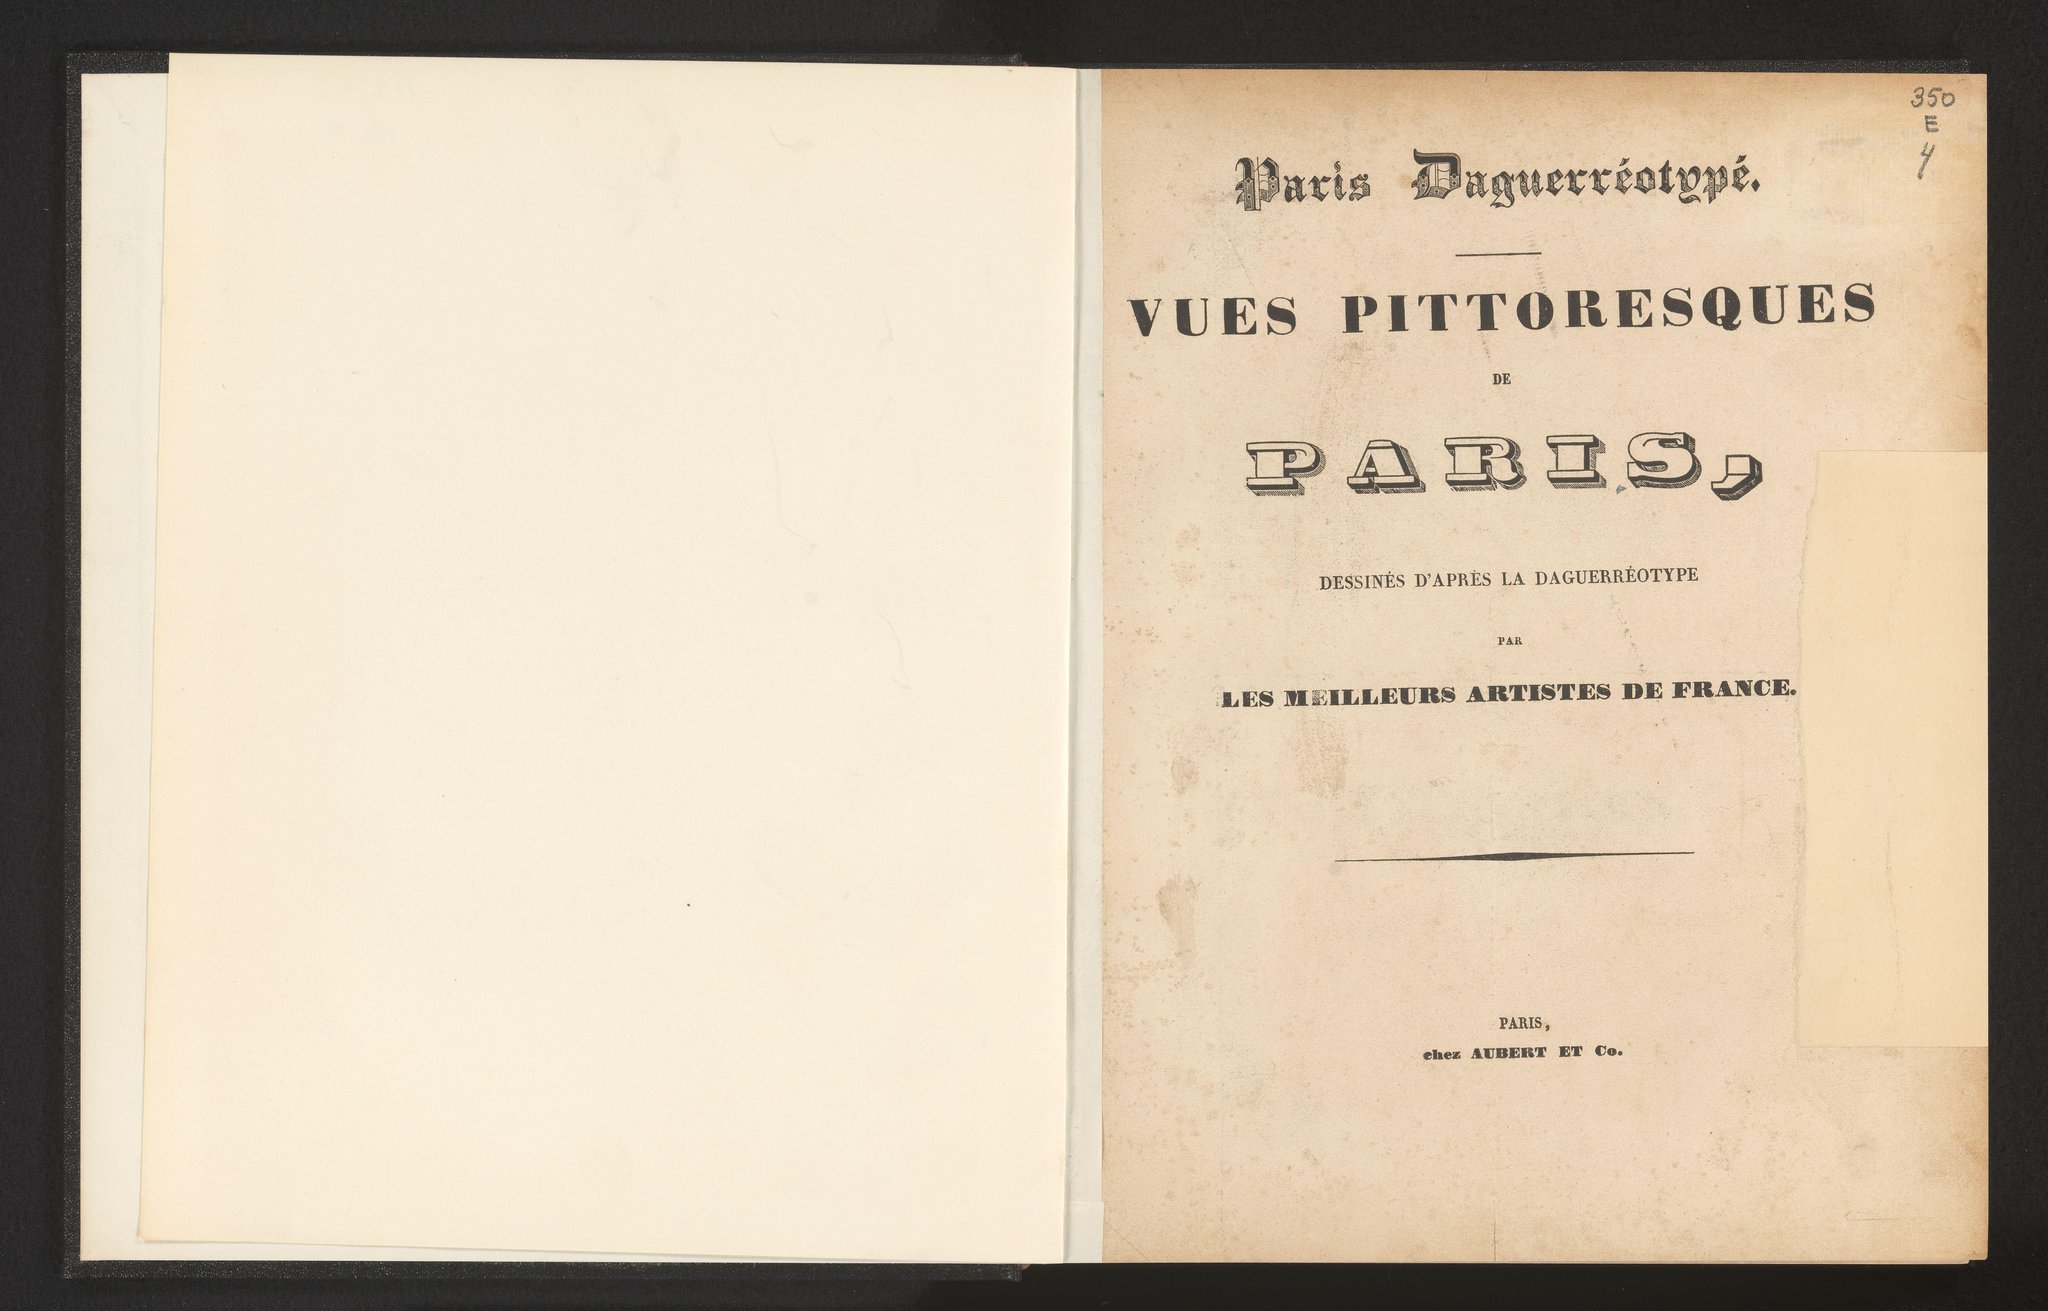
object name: book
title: Paris daguerréotypé : vues pittoresques de Paris, dessinés d'apres la daguerréotype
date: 1840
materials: cardboard, paper, textile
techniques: letterpress printing, lithograph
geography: paris